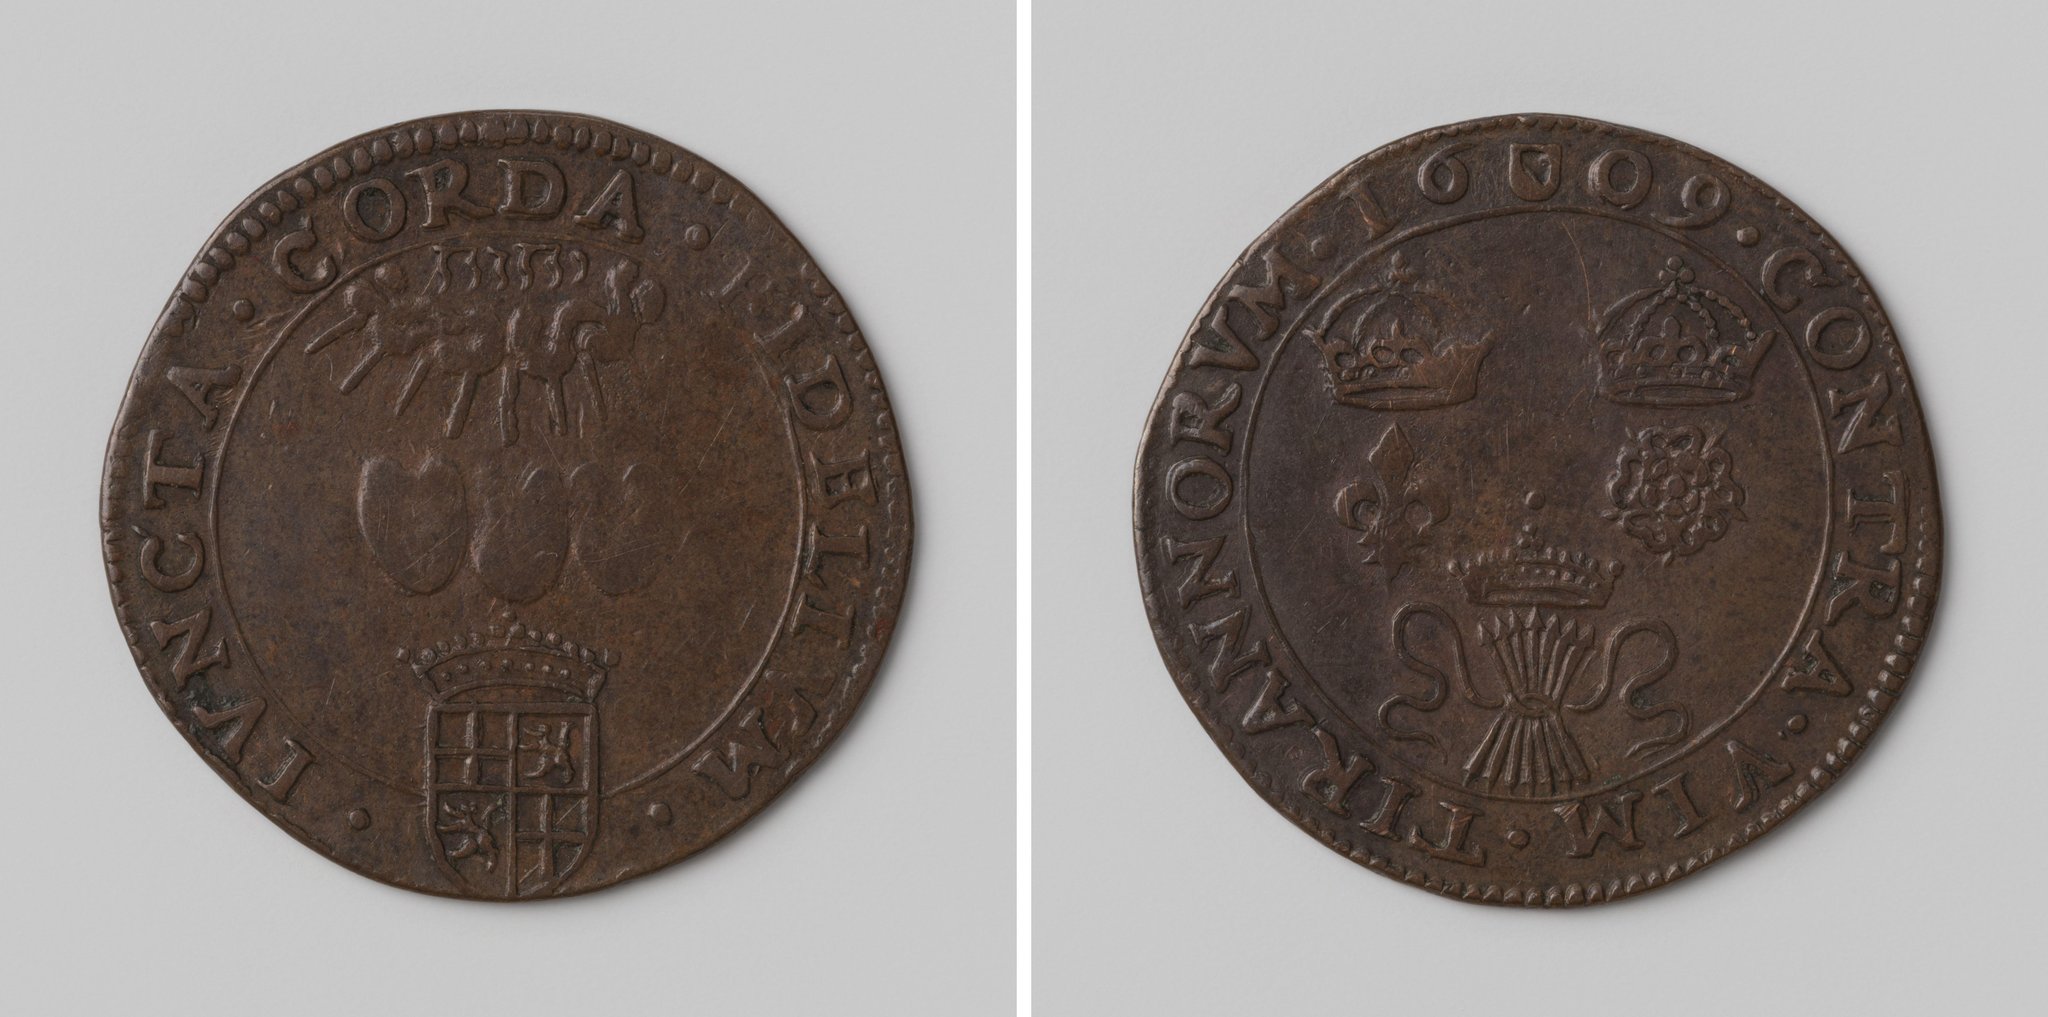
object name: jeton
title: Sluiting van het Twaalfjarig Bestand tussen de Republiek en Spanje, en hernieuwing van het drievoudige verbond tussen Engeland, Frankrijk en de Republiek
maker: Anonymous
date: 1609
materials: copper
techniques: striking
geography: utrecht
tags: netherlands, france, england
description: Koperen penning. Voorzijde: drie harten boven gekroond wapenschild, beschenen door hemellicht met daarin naam Jehovah in Hebreeuws schrift binnen omschrift. Keerzijde: lelie, roos en bundel van zeven pijlen, elk onder eigen kroon binnen omschrift.